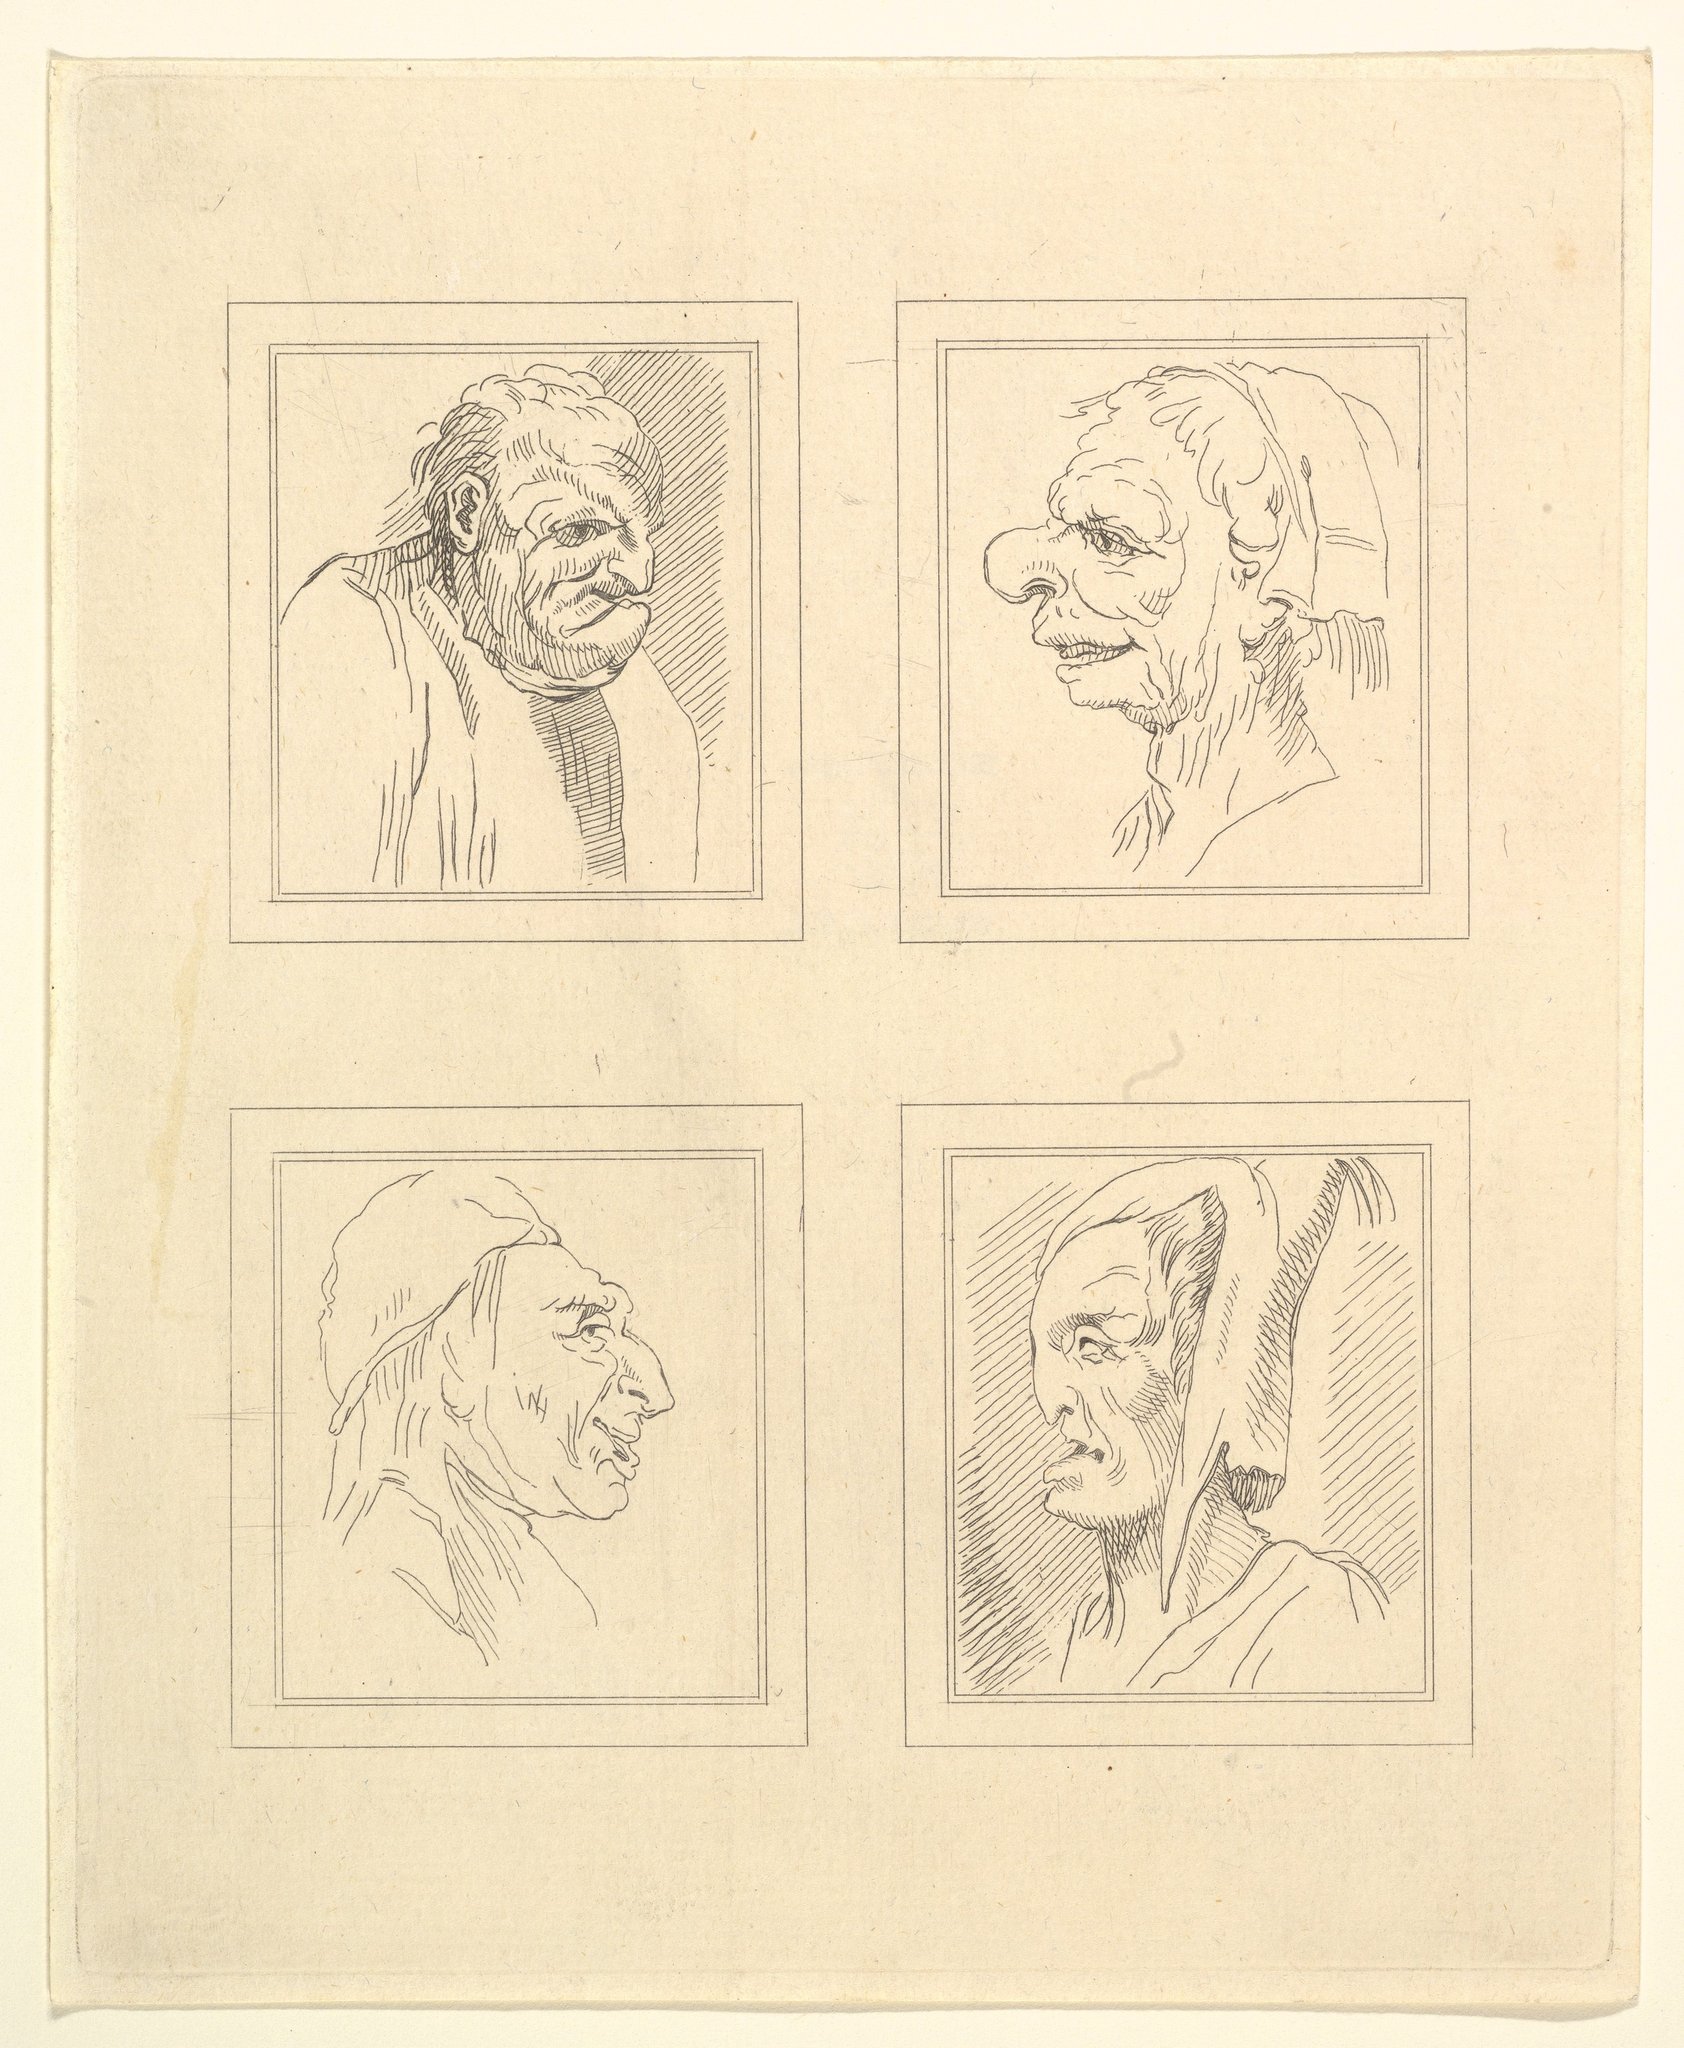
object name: print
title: Four Heads (from Characaturas by Leonardo da Vinci, from Drawings by Wincelslaus Hollar, out of the Portland Museum)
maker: wenceslaus hollar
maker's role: artist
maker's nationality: bohemian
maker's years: 1607-1677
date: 1786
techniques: etching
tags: heads,profiles